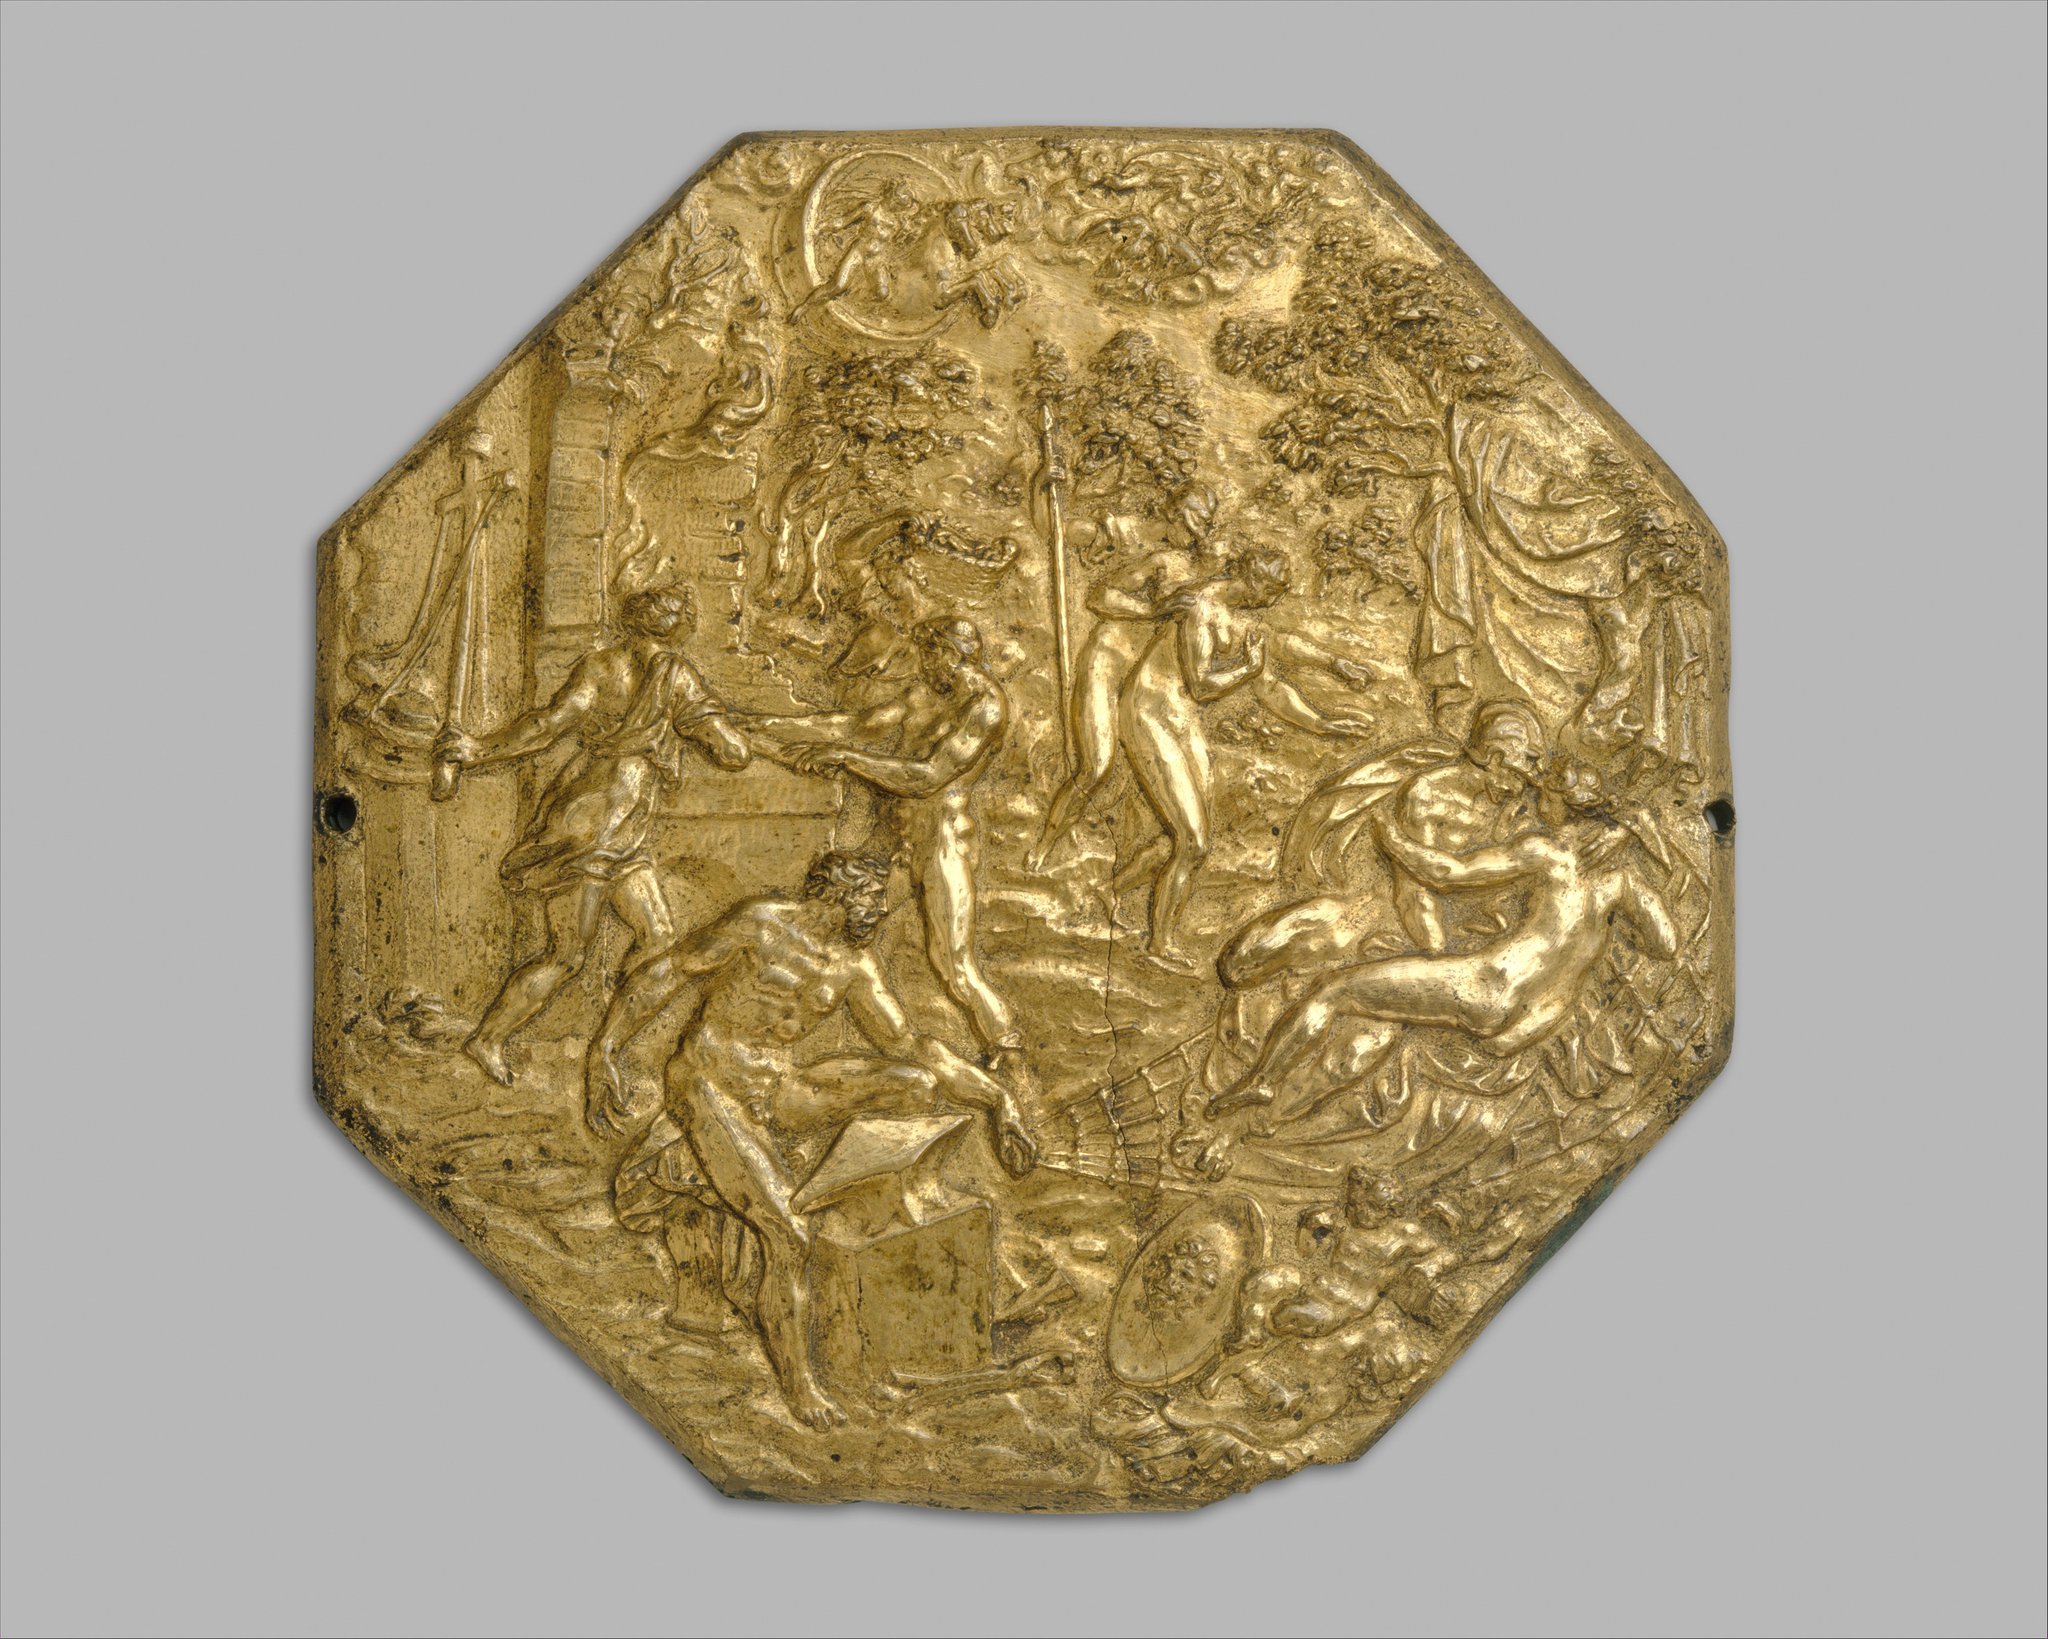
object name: plaquette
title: Mars and Venus Trapped by Vulcan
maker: guglielmo della porta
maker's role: artist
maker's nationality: italian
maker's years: 1500-1577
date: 1567-1600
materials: gilt bronze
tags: mars,venus,vulcan